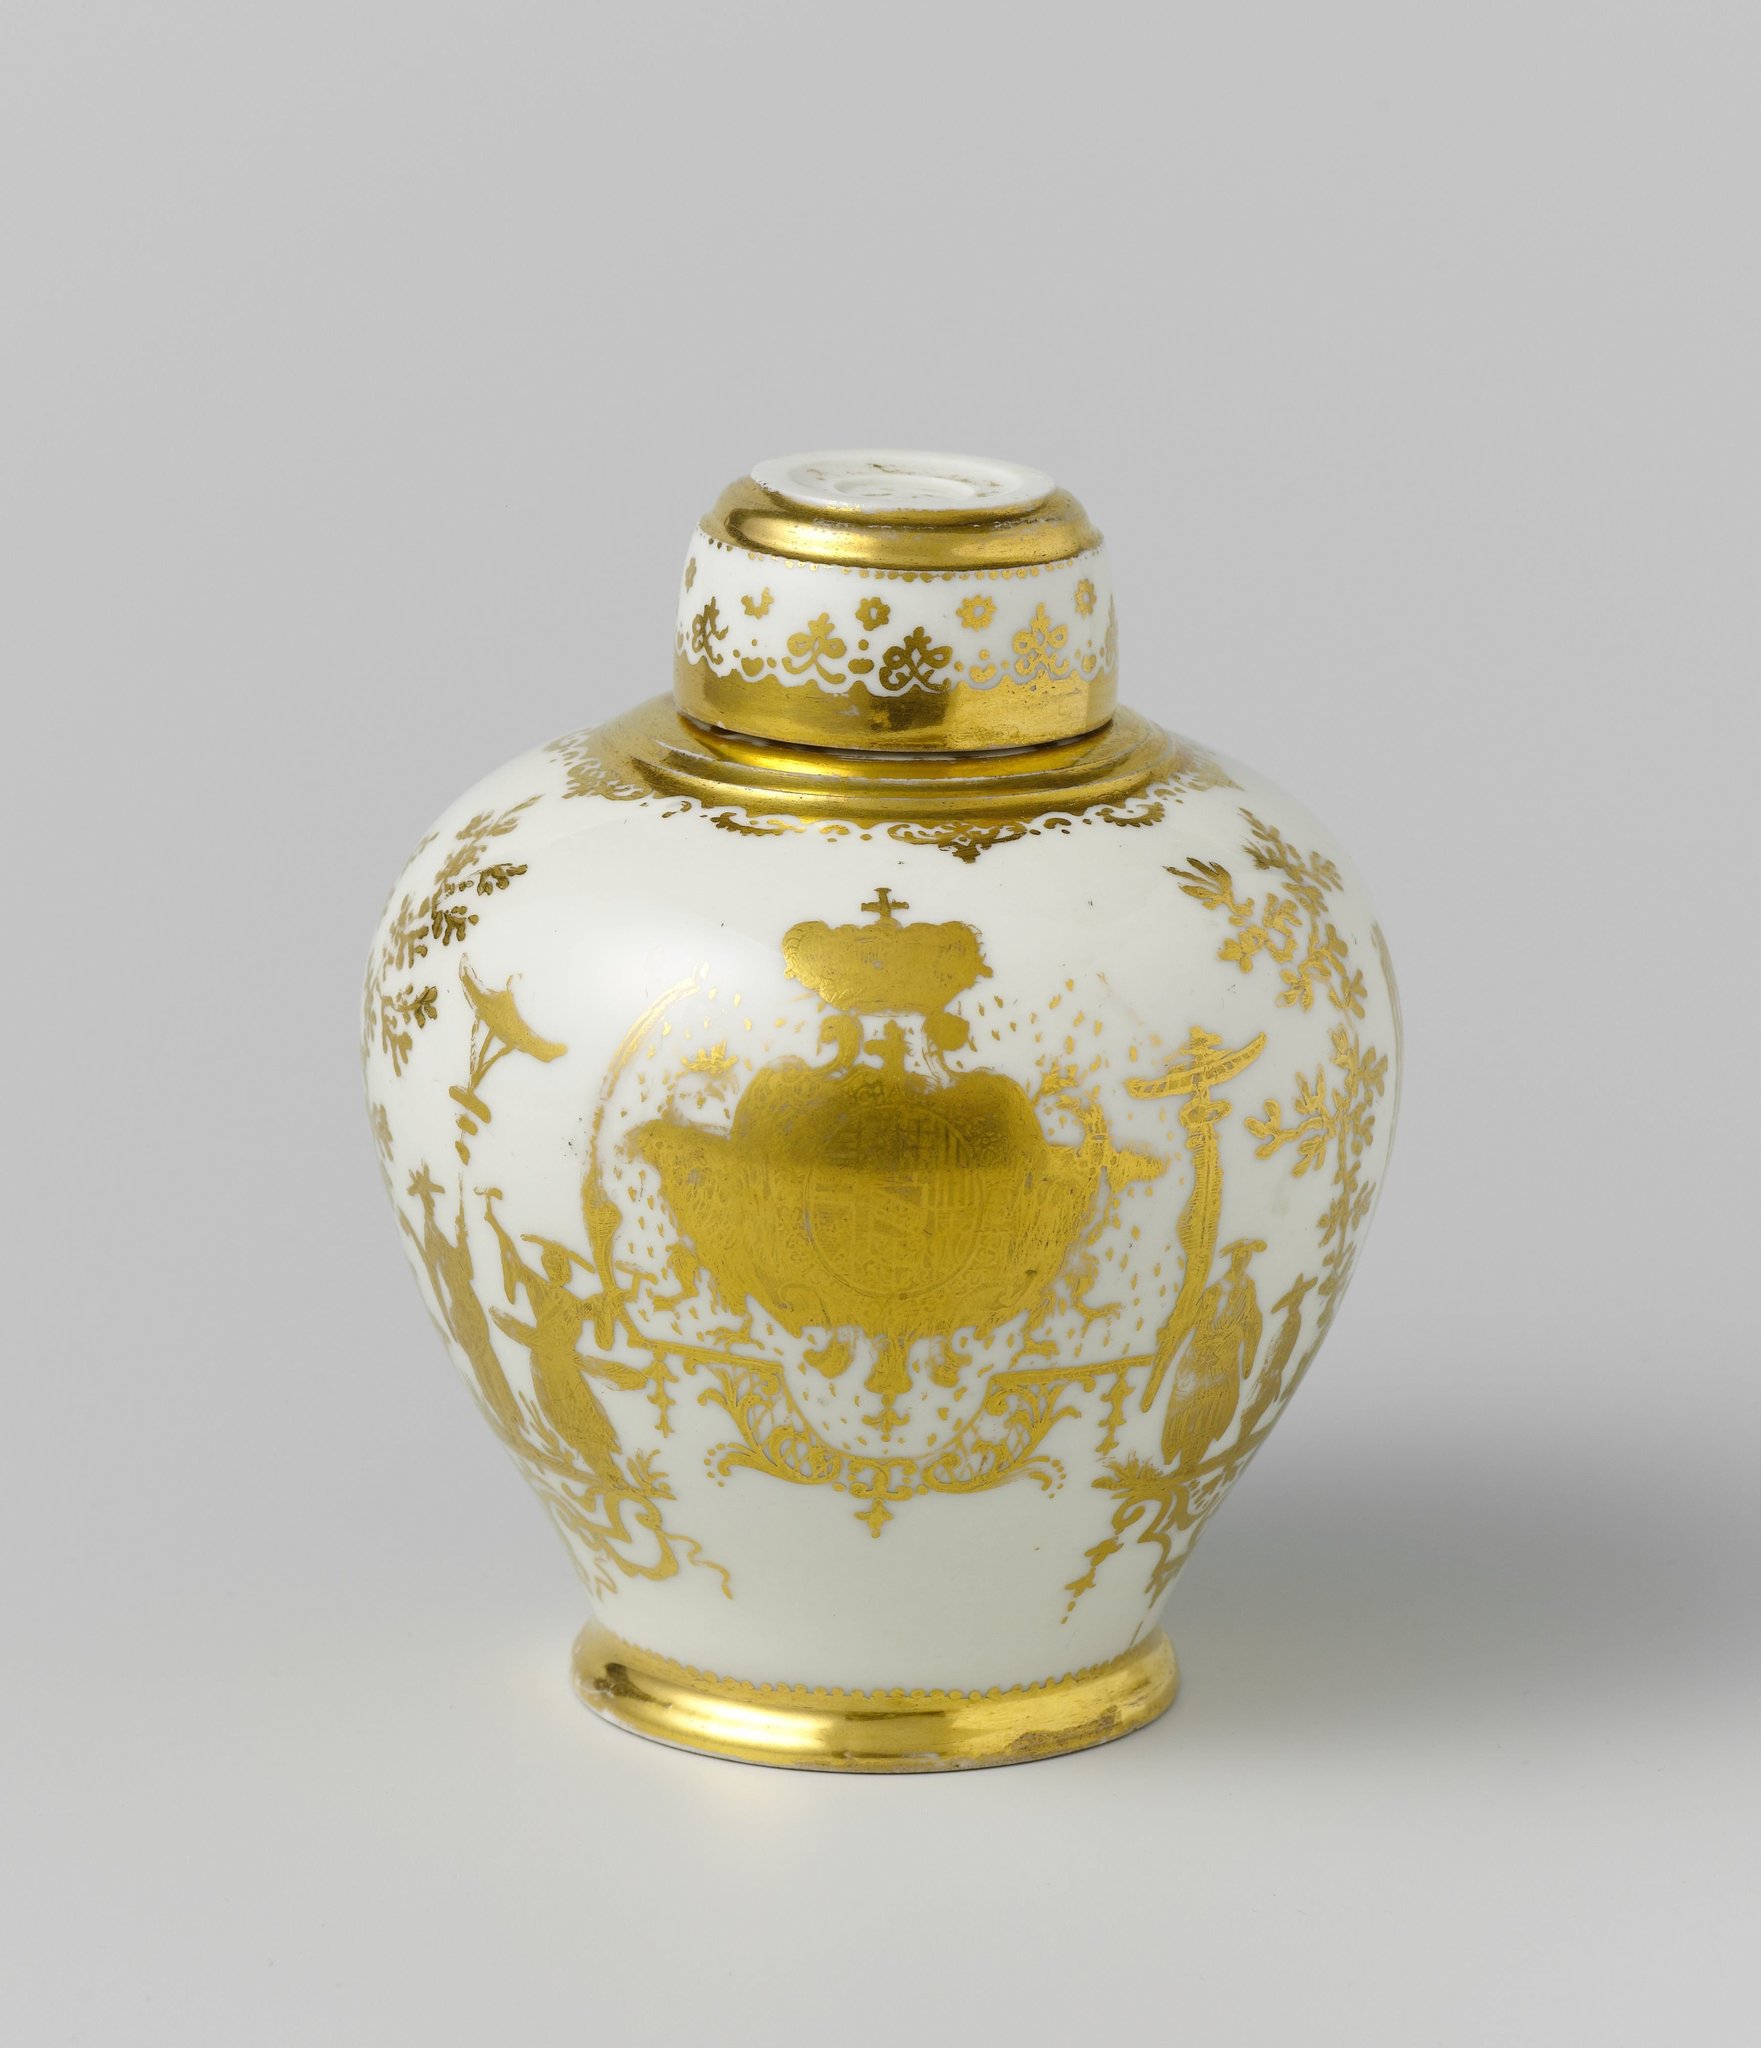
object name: eating drinking utensil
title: Tea caddy with the arms of the Dukes of Lorraine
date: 1737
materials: porcelain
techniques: painted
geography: augsburg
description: Meissener Porzellan Manufaktur Meissen, c. 1730 painted decoration: Seuter family workshop, Augsburg, c. 1737 hard-paste porcelain